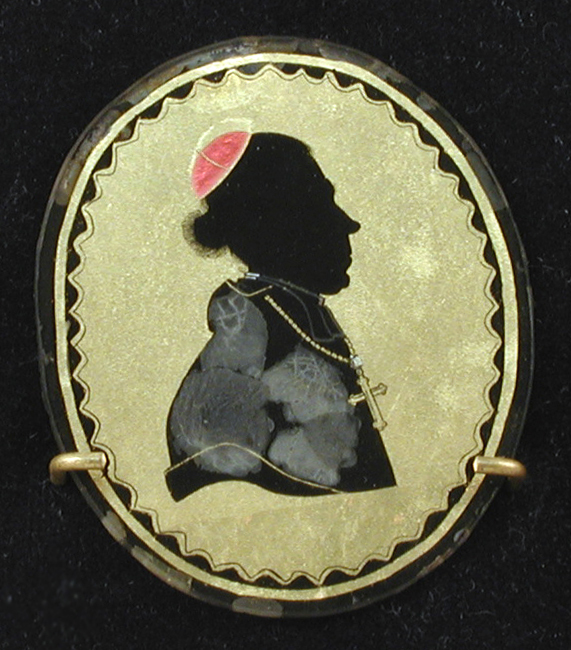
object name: medallion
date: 1801-1833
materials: glass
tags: men,profiles,cross